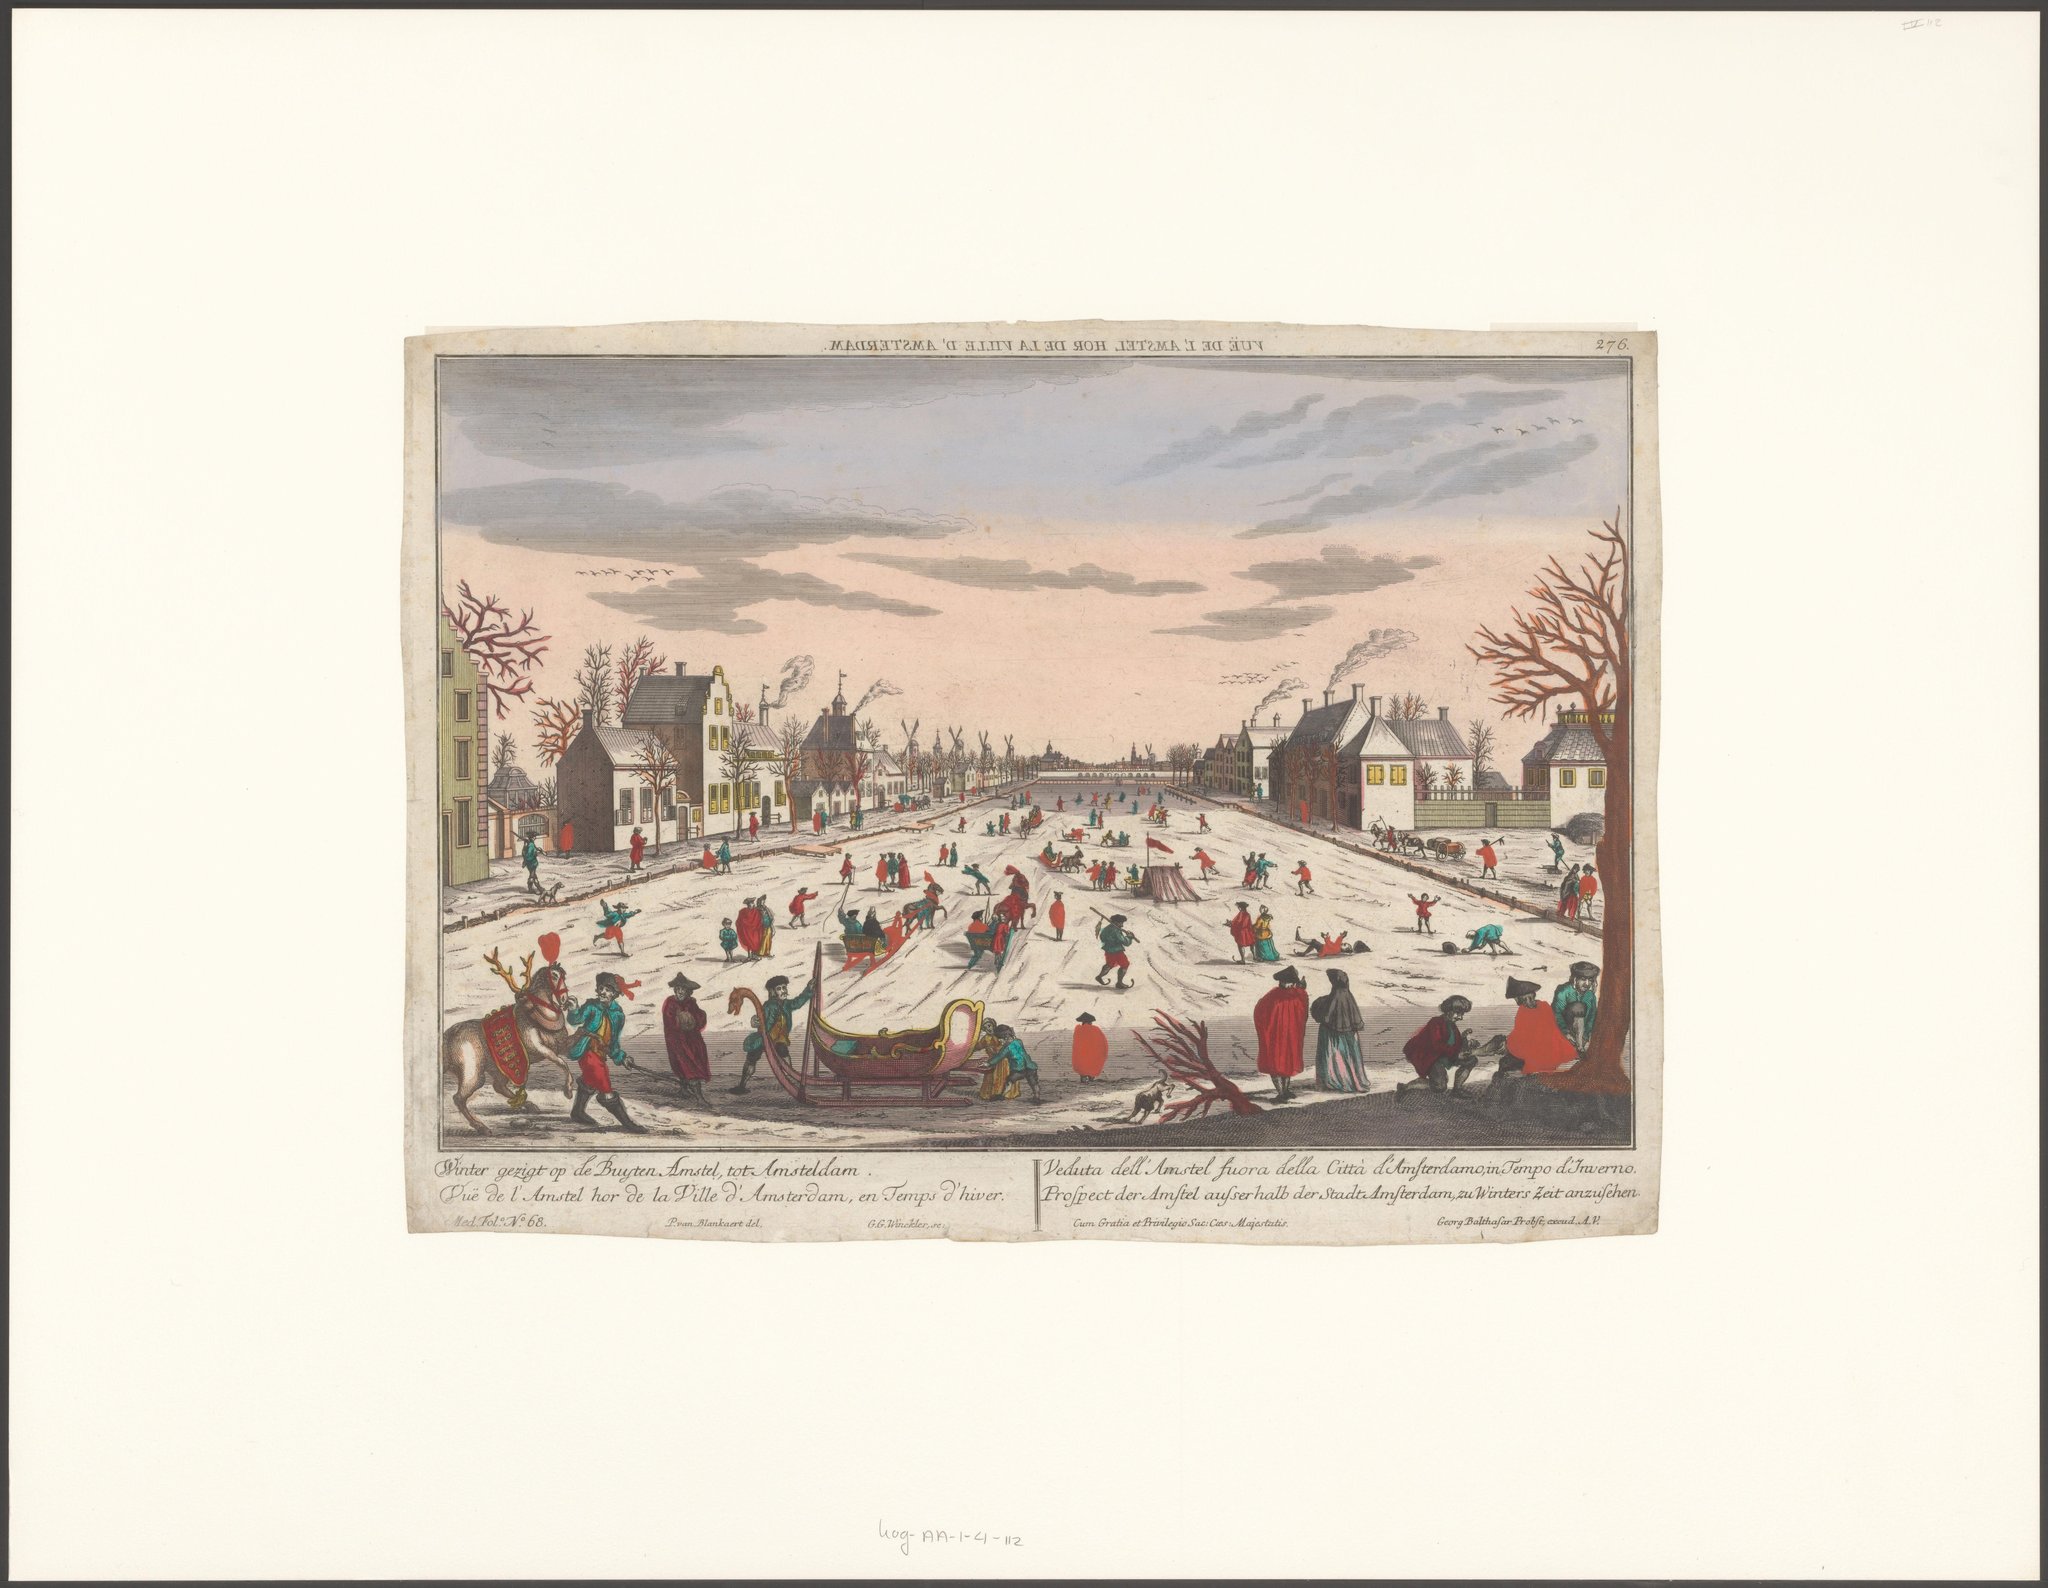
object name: print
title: Wintergezicht op de Buiten-Amstel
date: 1766-1786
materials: paper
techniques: etching, hand coloring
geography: augsburg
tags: city-view in general; 'veduta', river, winter landscape; landscape symbolizing winter (the four seasons of the year), skates (winter sports), bridge in city across river, canal, etc.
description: Onderwerpsrubriek binnen de Atlas Amsterdam: Amstel van Hogesluis stroomopwaarts. Genummerd rechtsboven: 276. Linksonder genummerd: 68.